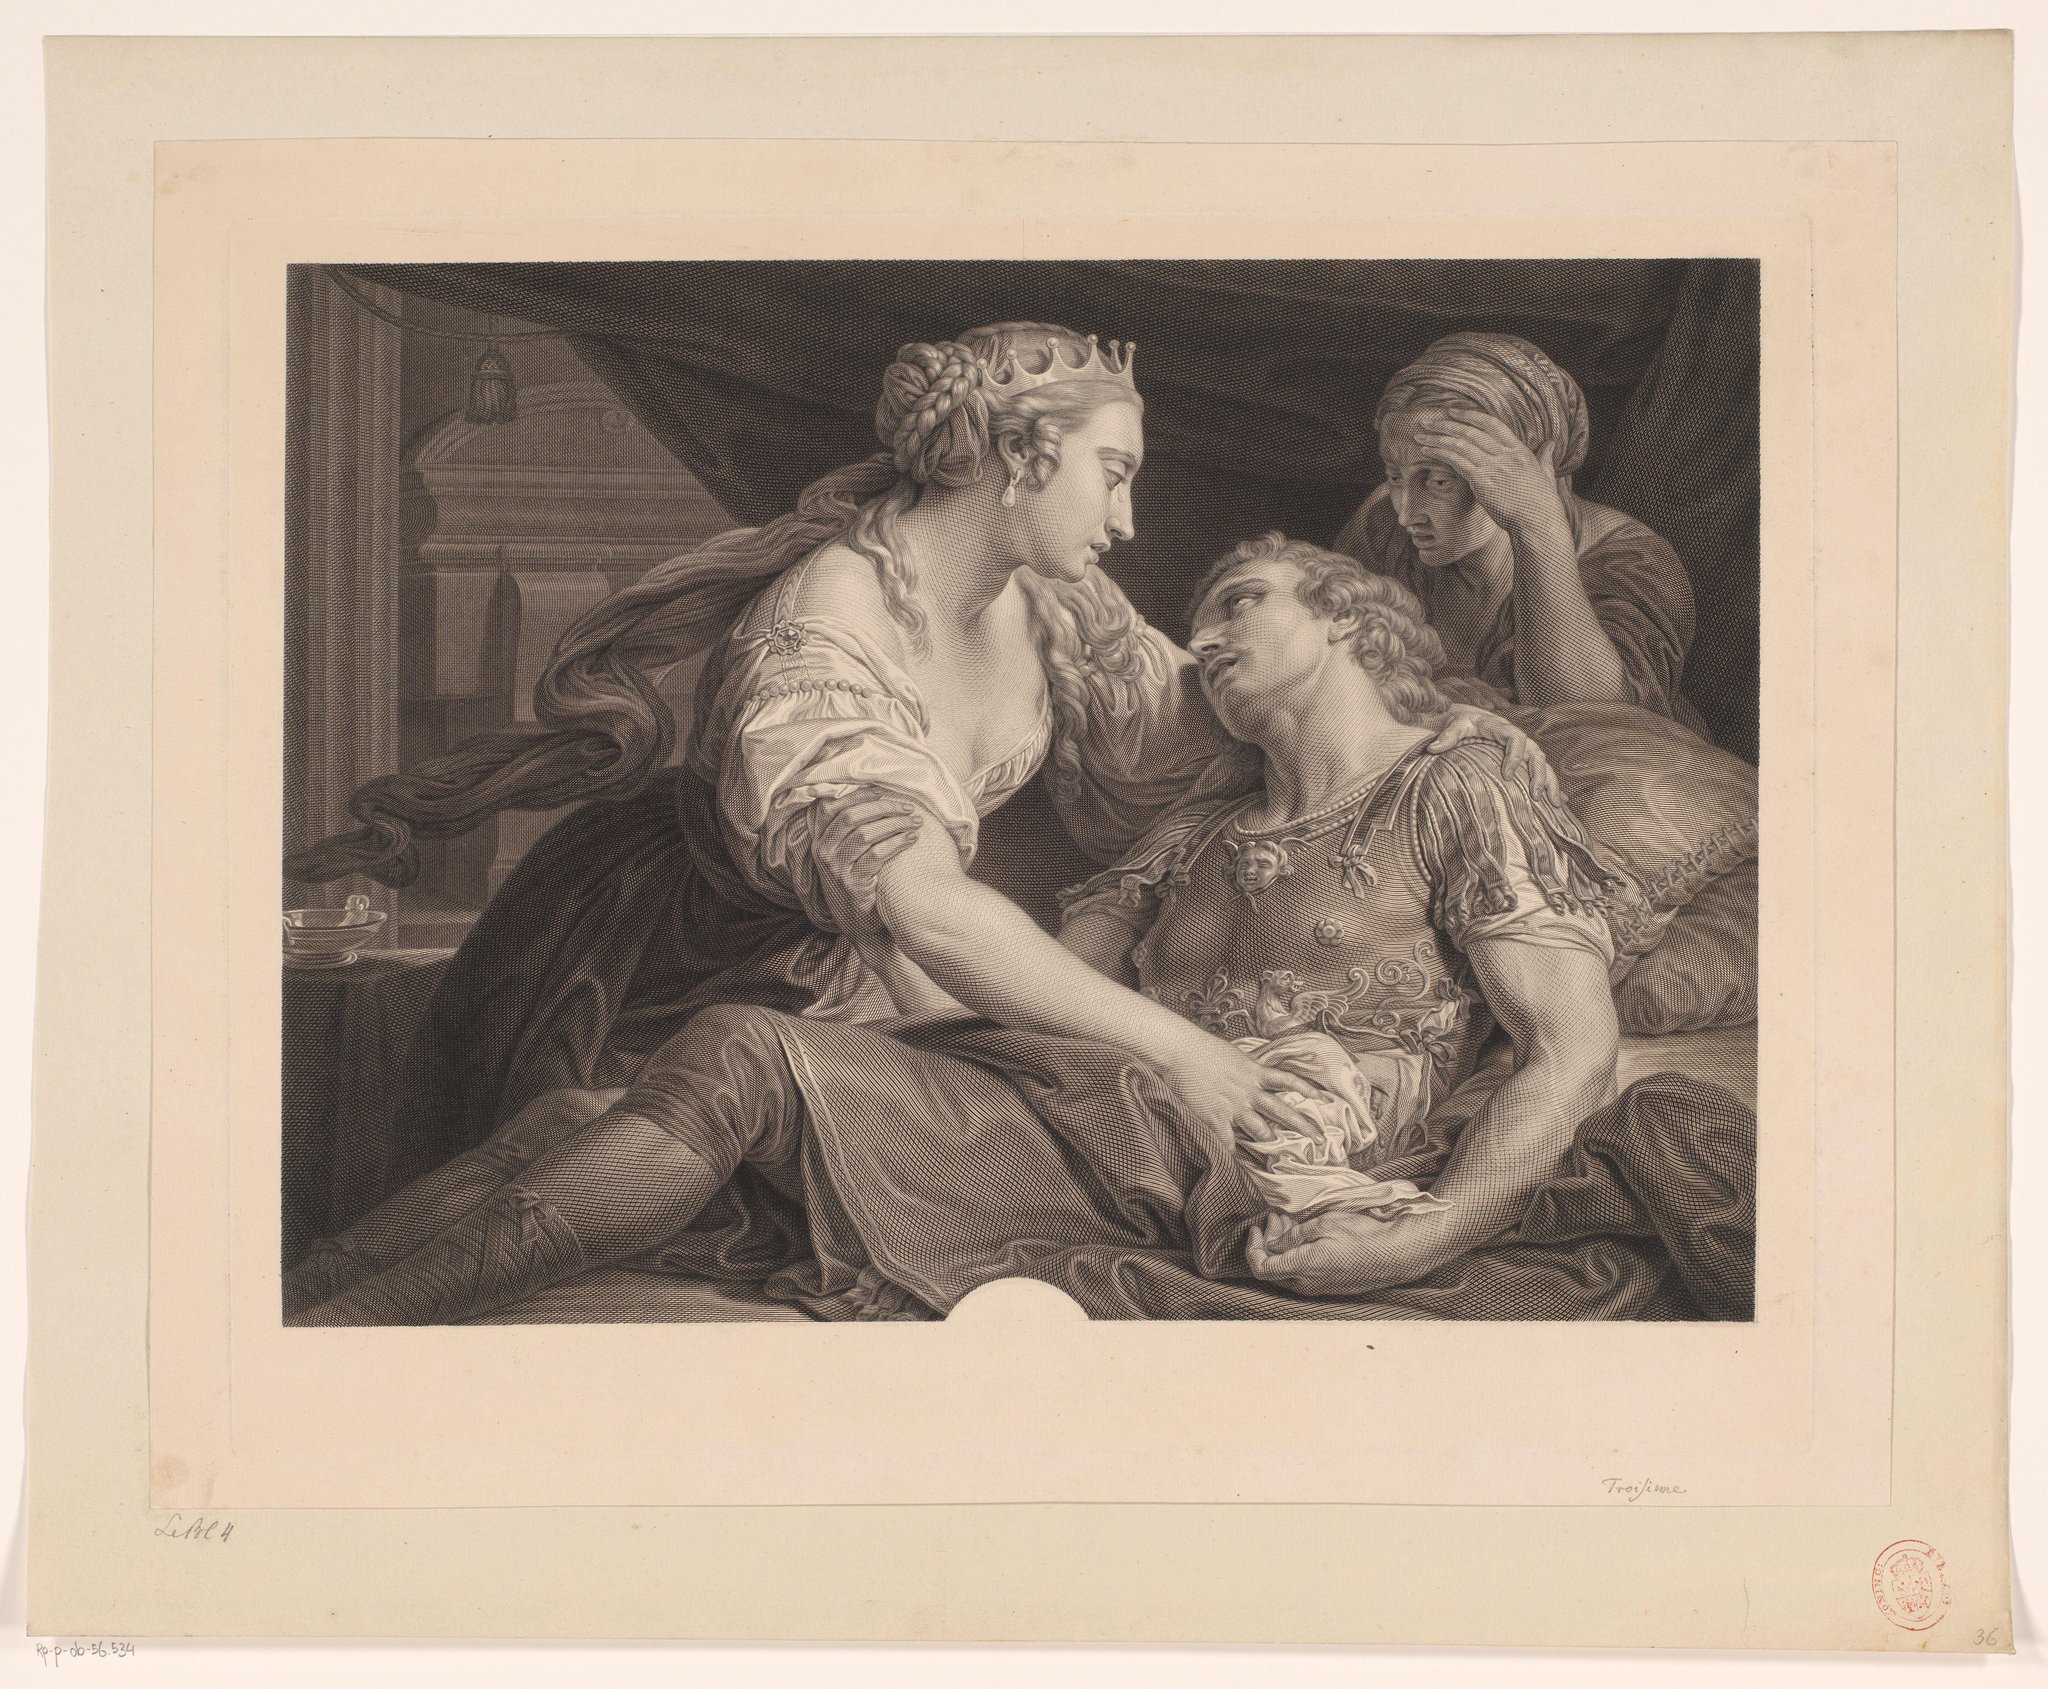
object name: print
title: Marcus Antonius sterft in de armen van Cleopatra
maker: johann georg wille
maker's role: draughtsman, print maker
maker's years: 1715-1808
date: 1778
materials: paper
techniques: engraving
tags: death of mark antony: he dies after having stabbed himself: cleopatra grieves at his bedside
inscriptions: collector's mark: Lugt 240